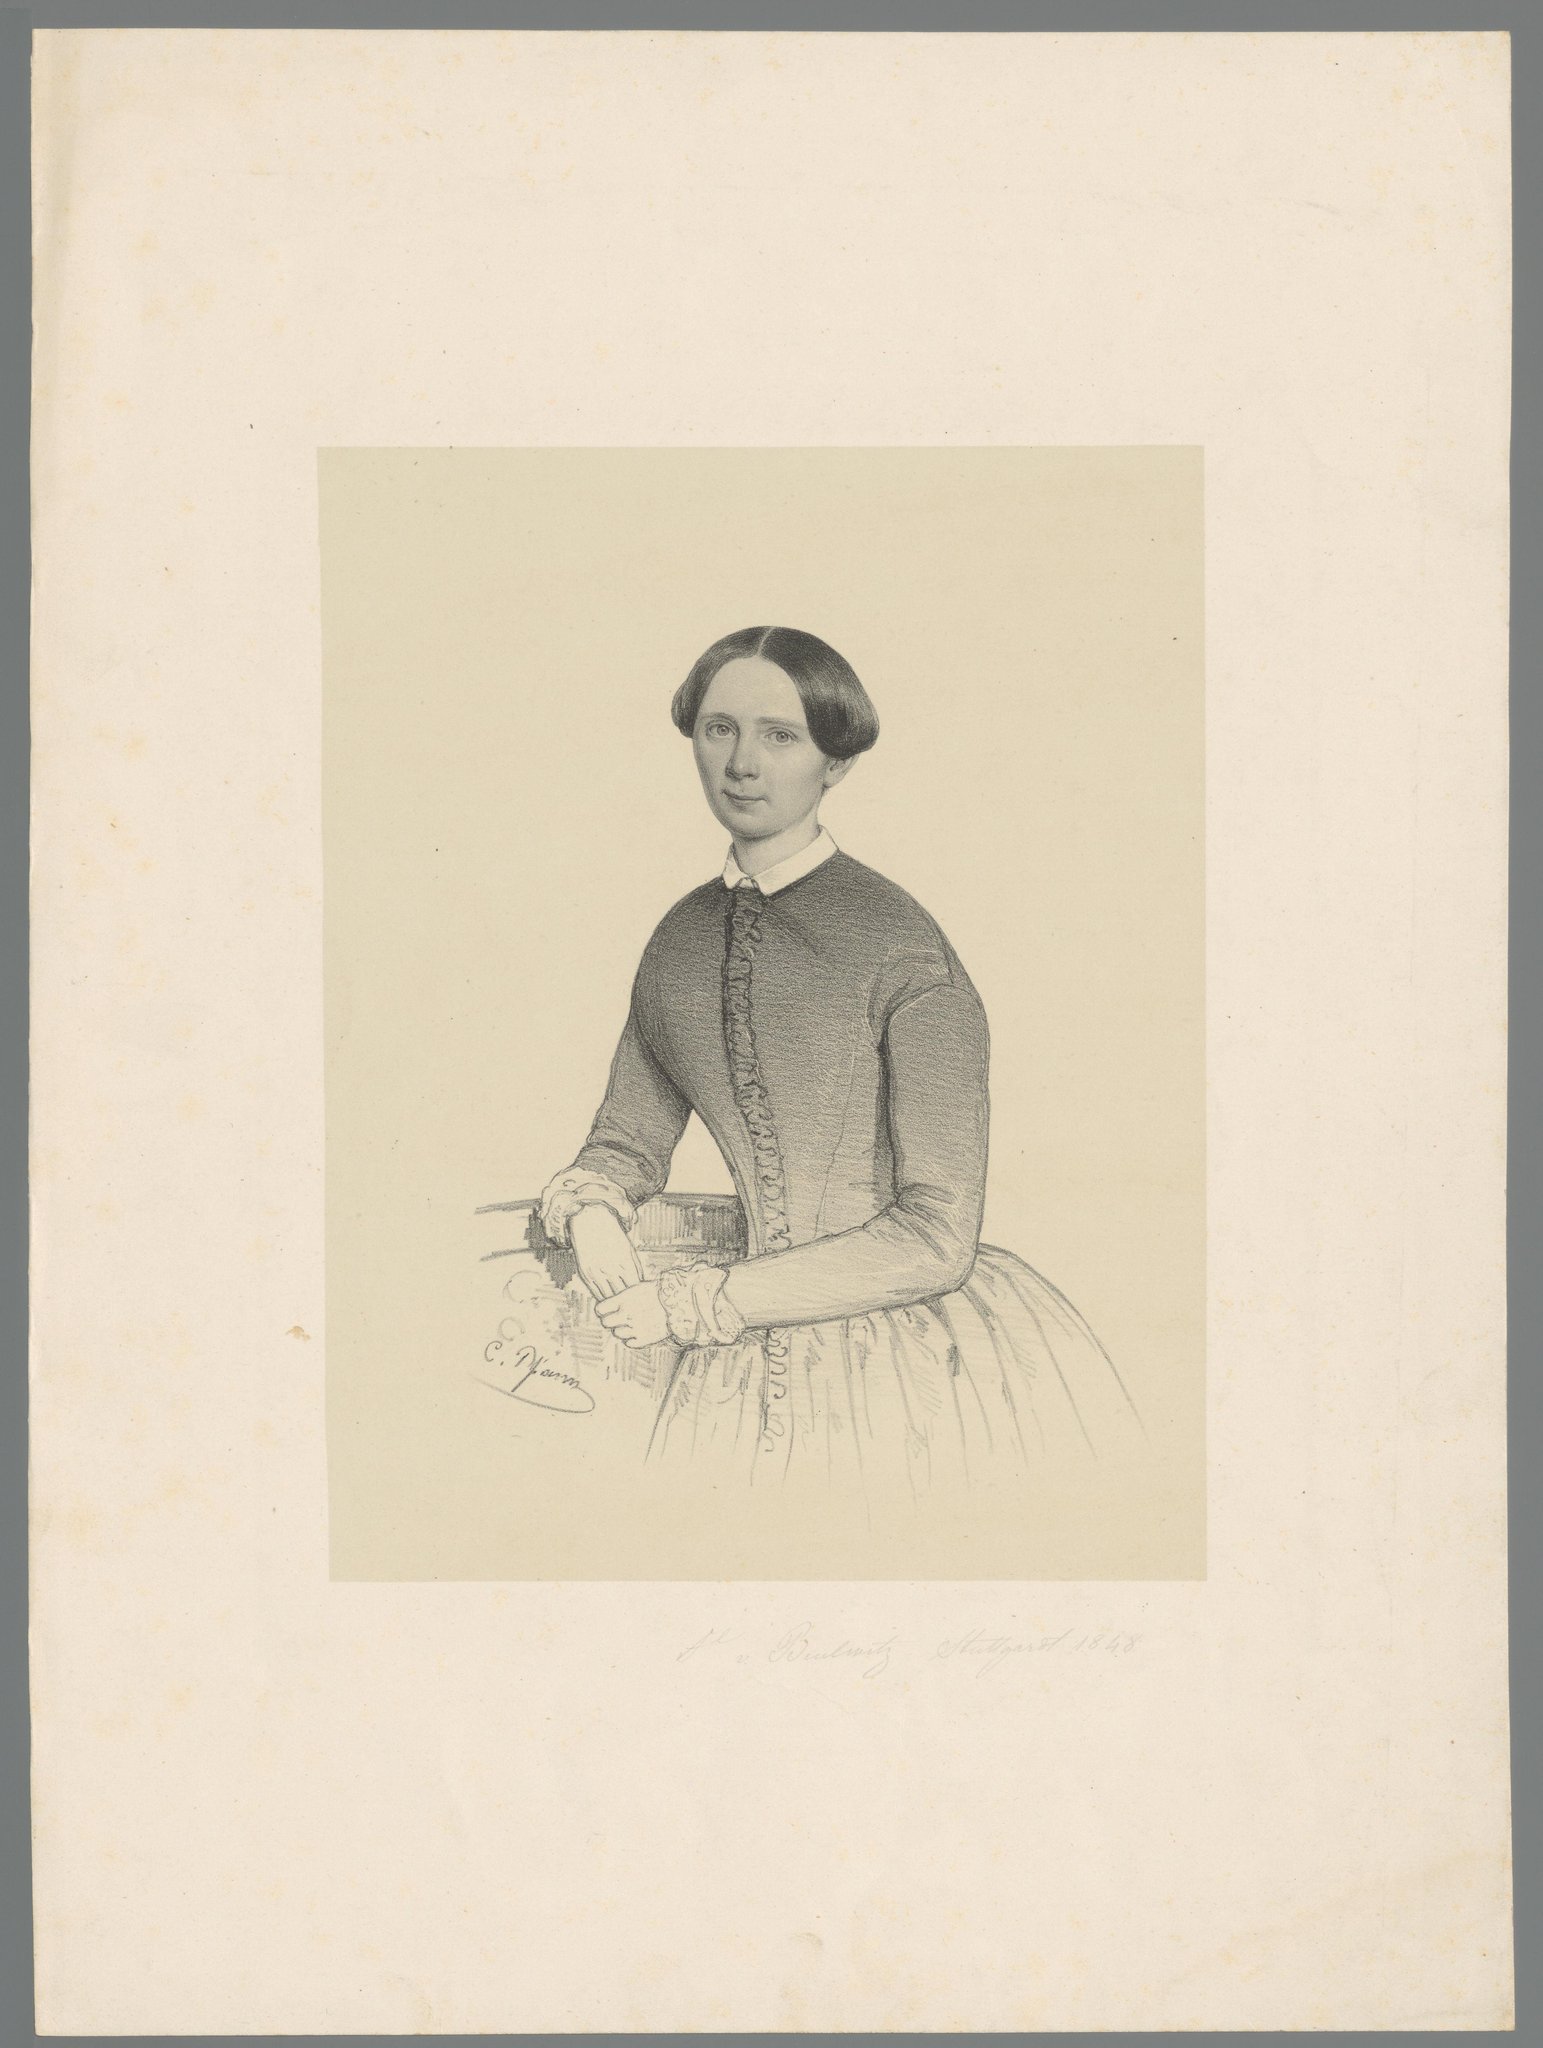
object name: print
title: Portret van een onbekende vrouw, mogelijk Beulwitz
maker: christian pfann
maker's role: print maker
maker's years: 1824-1885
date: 1834-1885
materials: paper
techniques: lithograph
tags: adult woman, historical persons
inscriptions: collector's mark: Lugt 2228